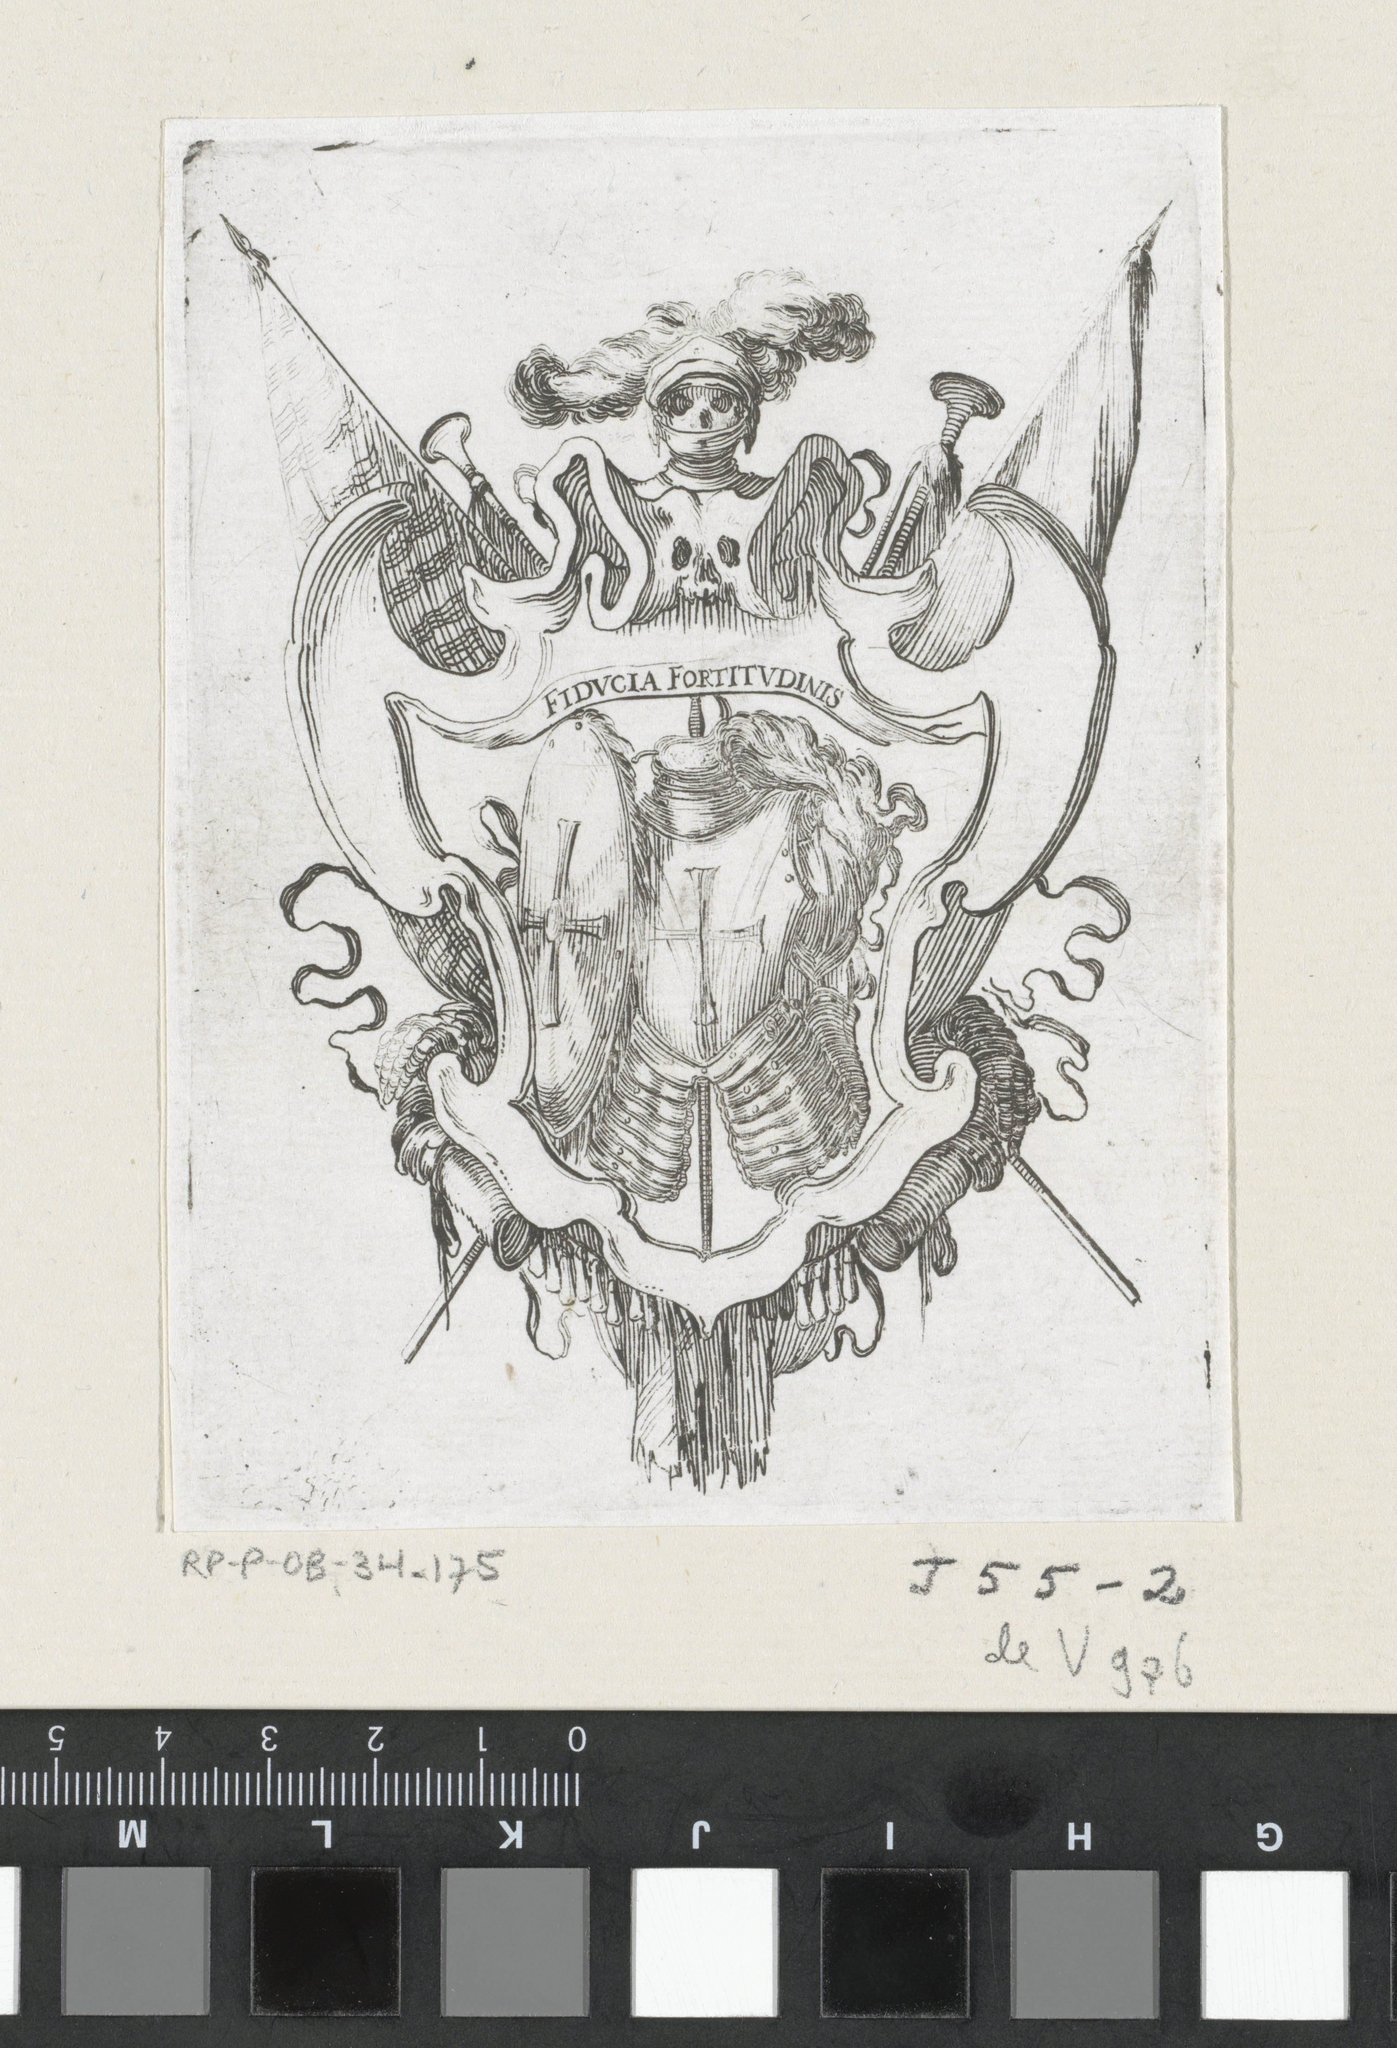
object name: print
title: Acht cartouches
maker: stefano della bella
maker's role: draughtsman, print maker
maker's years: 1610-1664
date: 1620-1664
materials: paper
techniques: etching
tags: protective weapons: shield, (human) skull, armour, ornament ~ cartouche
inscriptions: collector's mark: Lugt 240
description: Een cartouche met wapenrusting en een banderol met tekst. Achter het cartouche twee vlaggenstokken en bovenop een schedel met gevederde helm.